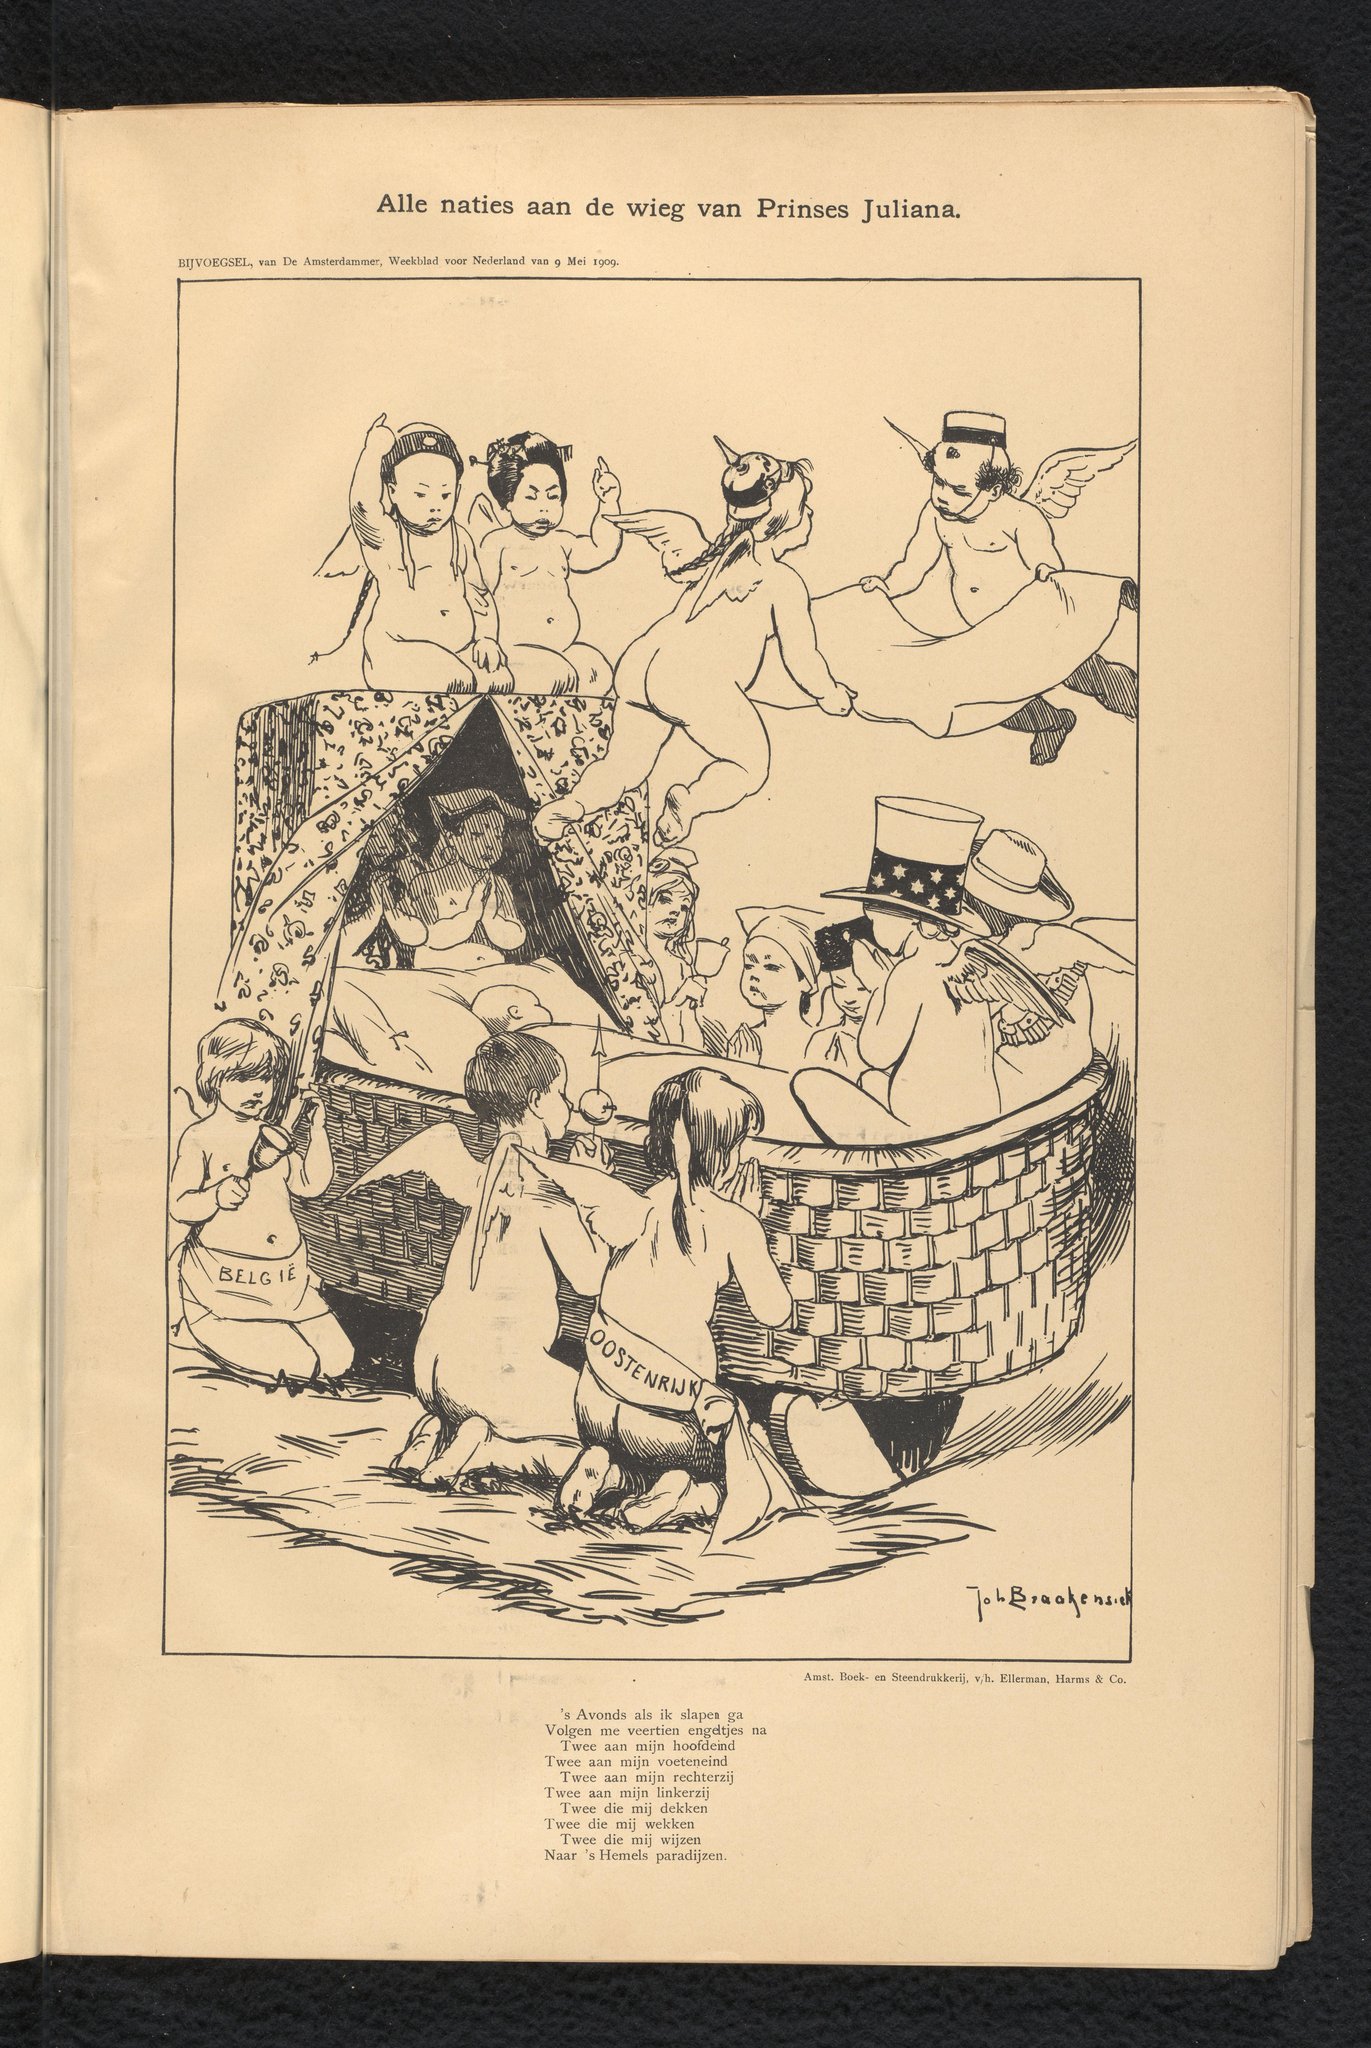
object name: cartoon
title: Alle naties aan de wieg van Prinses Juliana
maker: johan braakensiek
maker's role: draughtsman, print maker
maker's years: 1858-1940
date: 1909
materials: paper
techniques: lithograph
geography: amsterdam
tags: the hague, juliana of the netherlands, personifications of countries, nations, states, districts, etc., cradle, crib, political caricatures and satires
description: Engeltjes van verschillende landen van over de hele wereld rondom de wieg met de baby prinses Juliana. Onderaan de tekst van een liedje over veertien engeltjes.